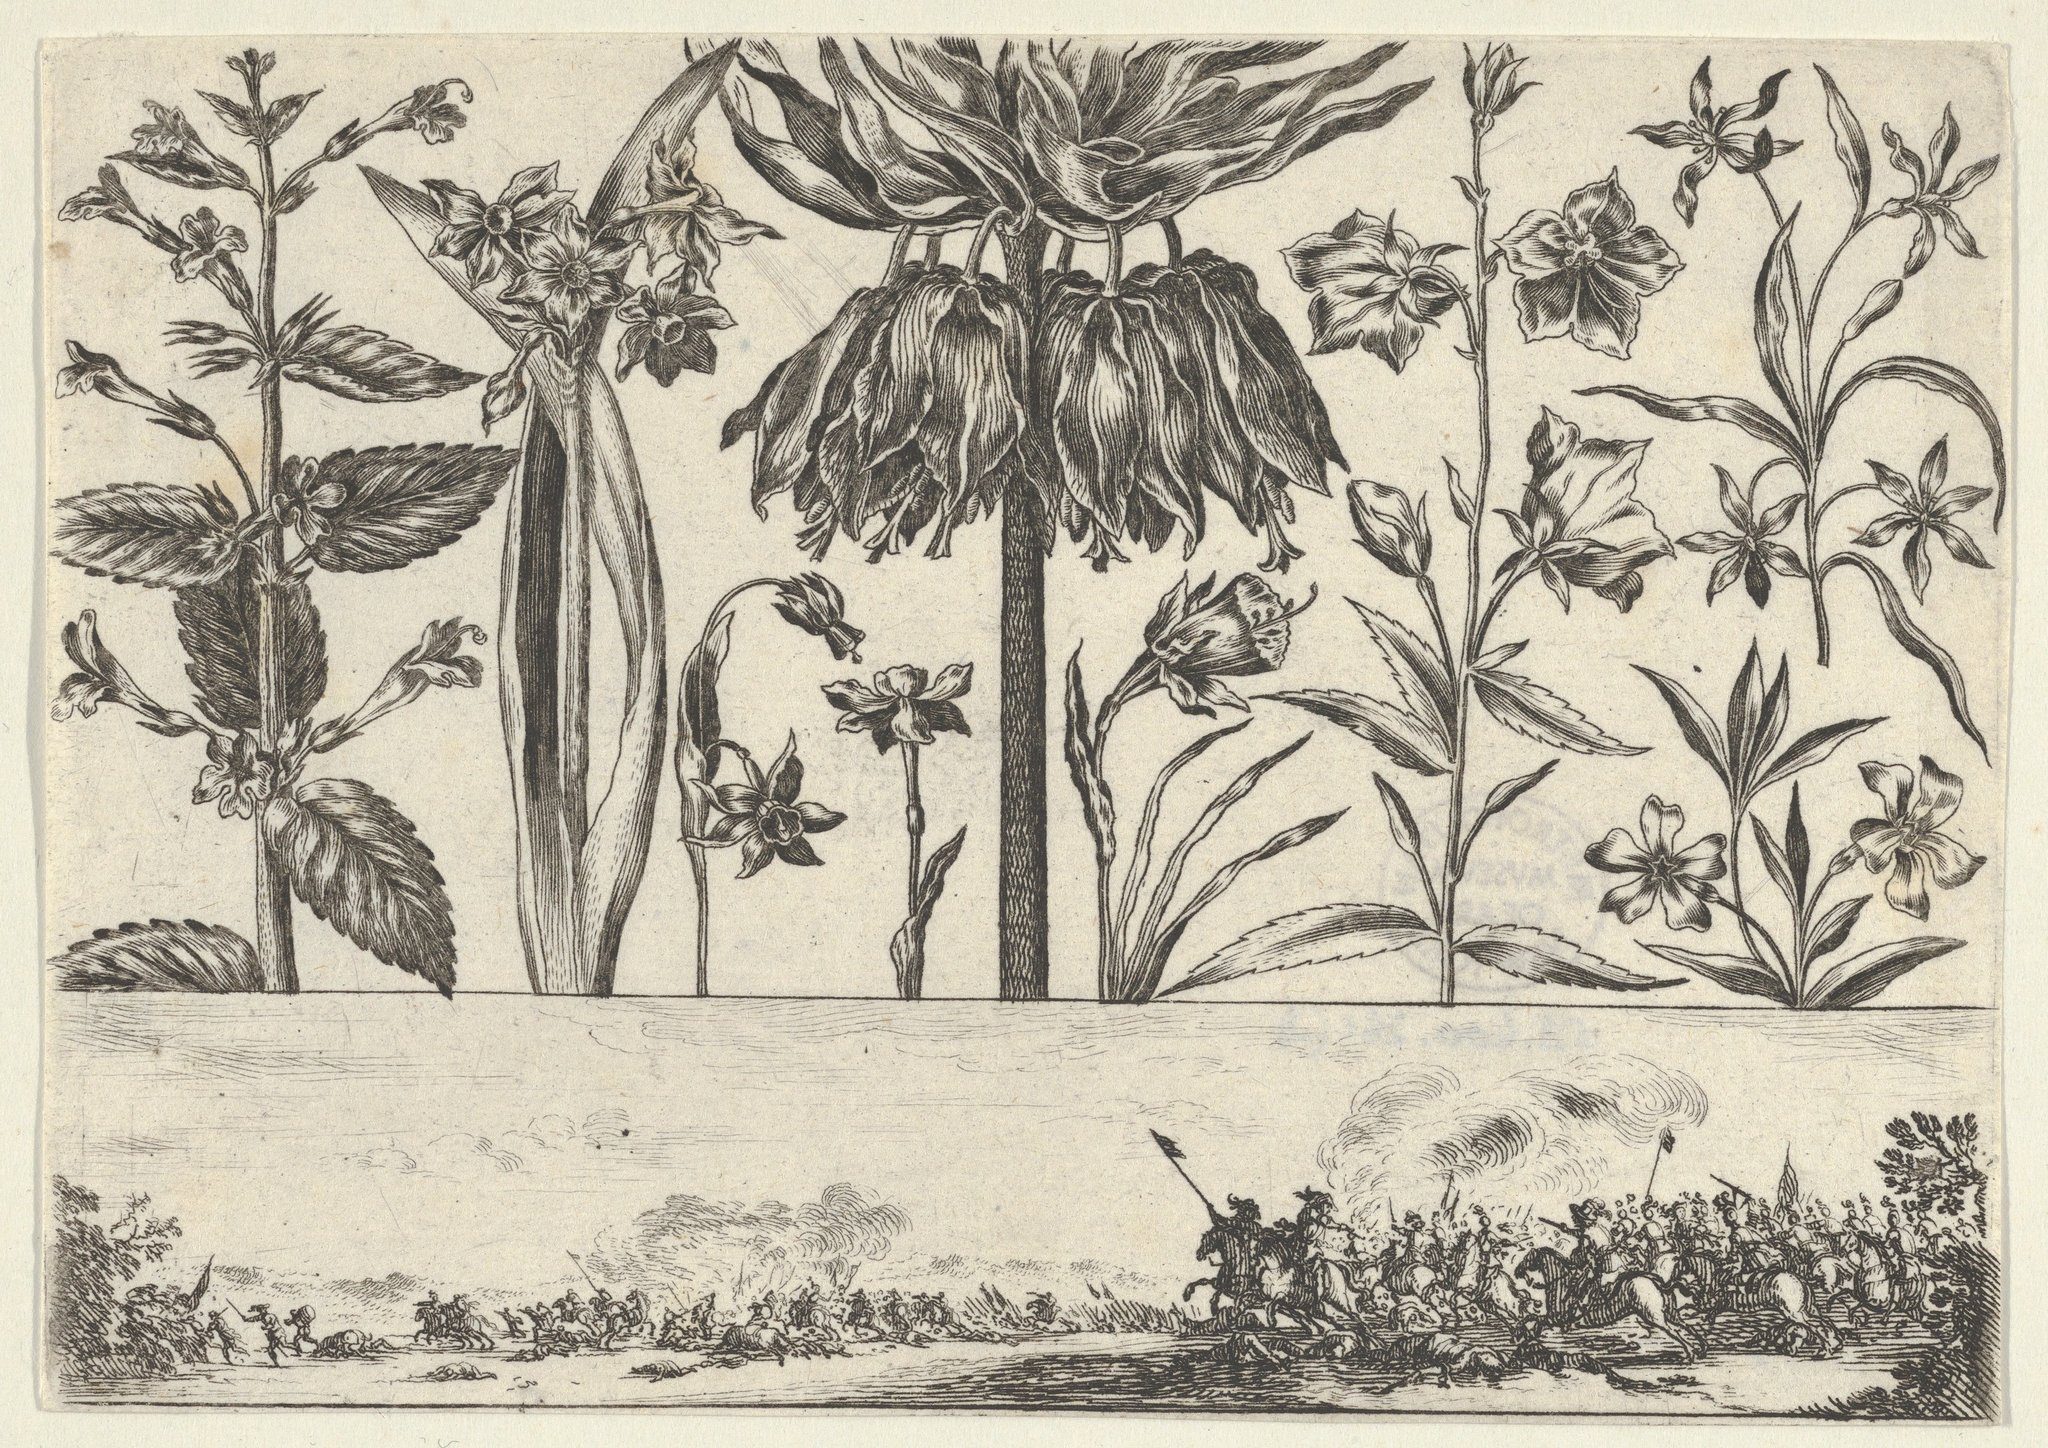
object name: print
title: Horizontal Panel with a Row of Flowers Above a Frieze with a Battle Scene in a Landscape, from "Livre Nouveau de Fleurs Tres-Util"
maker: nicolas cochin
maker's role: artist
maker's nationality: french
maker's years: 1610-1686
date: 1645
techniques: engraving, etching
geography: france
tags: human figures,horses,flowers,leaves